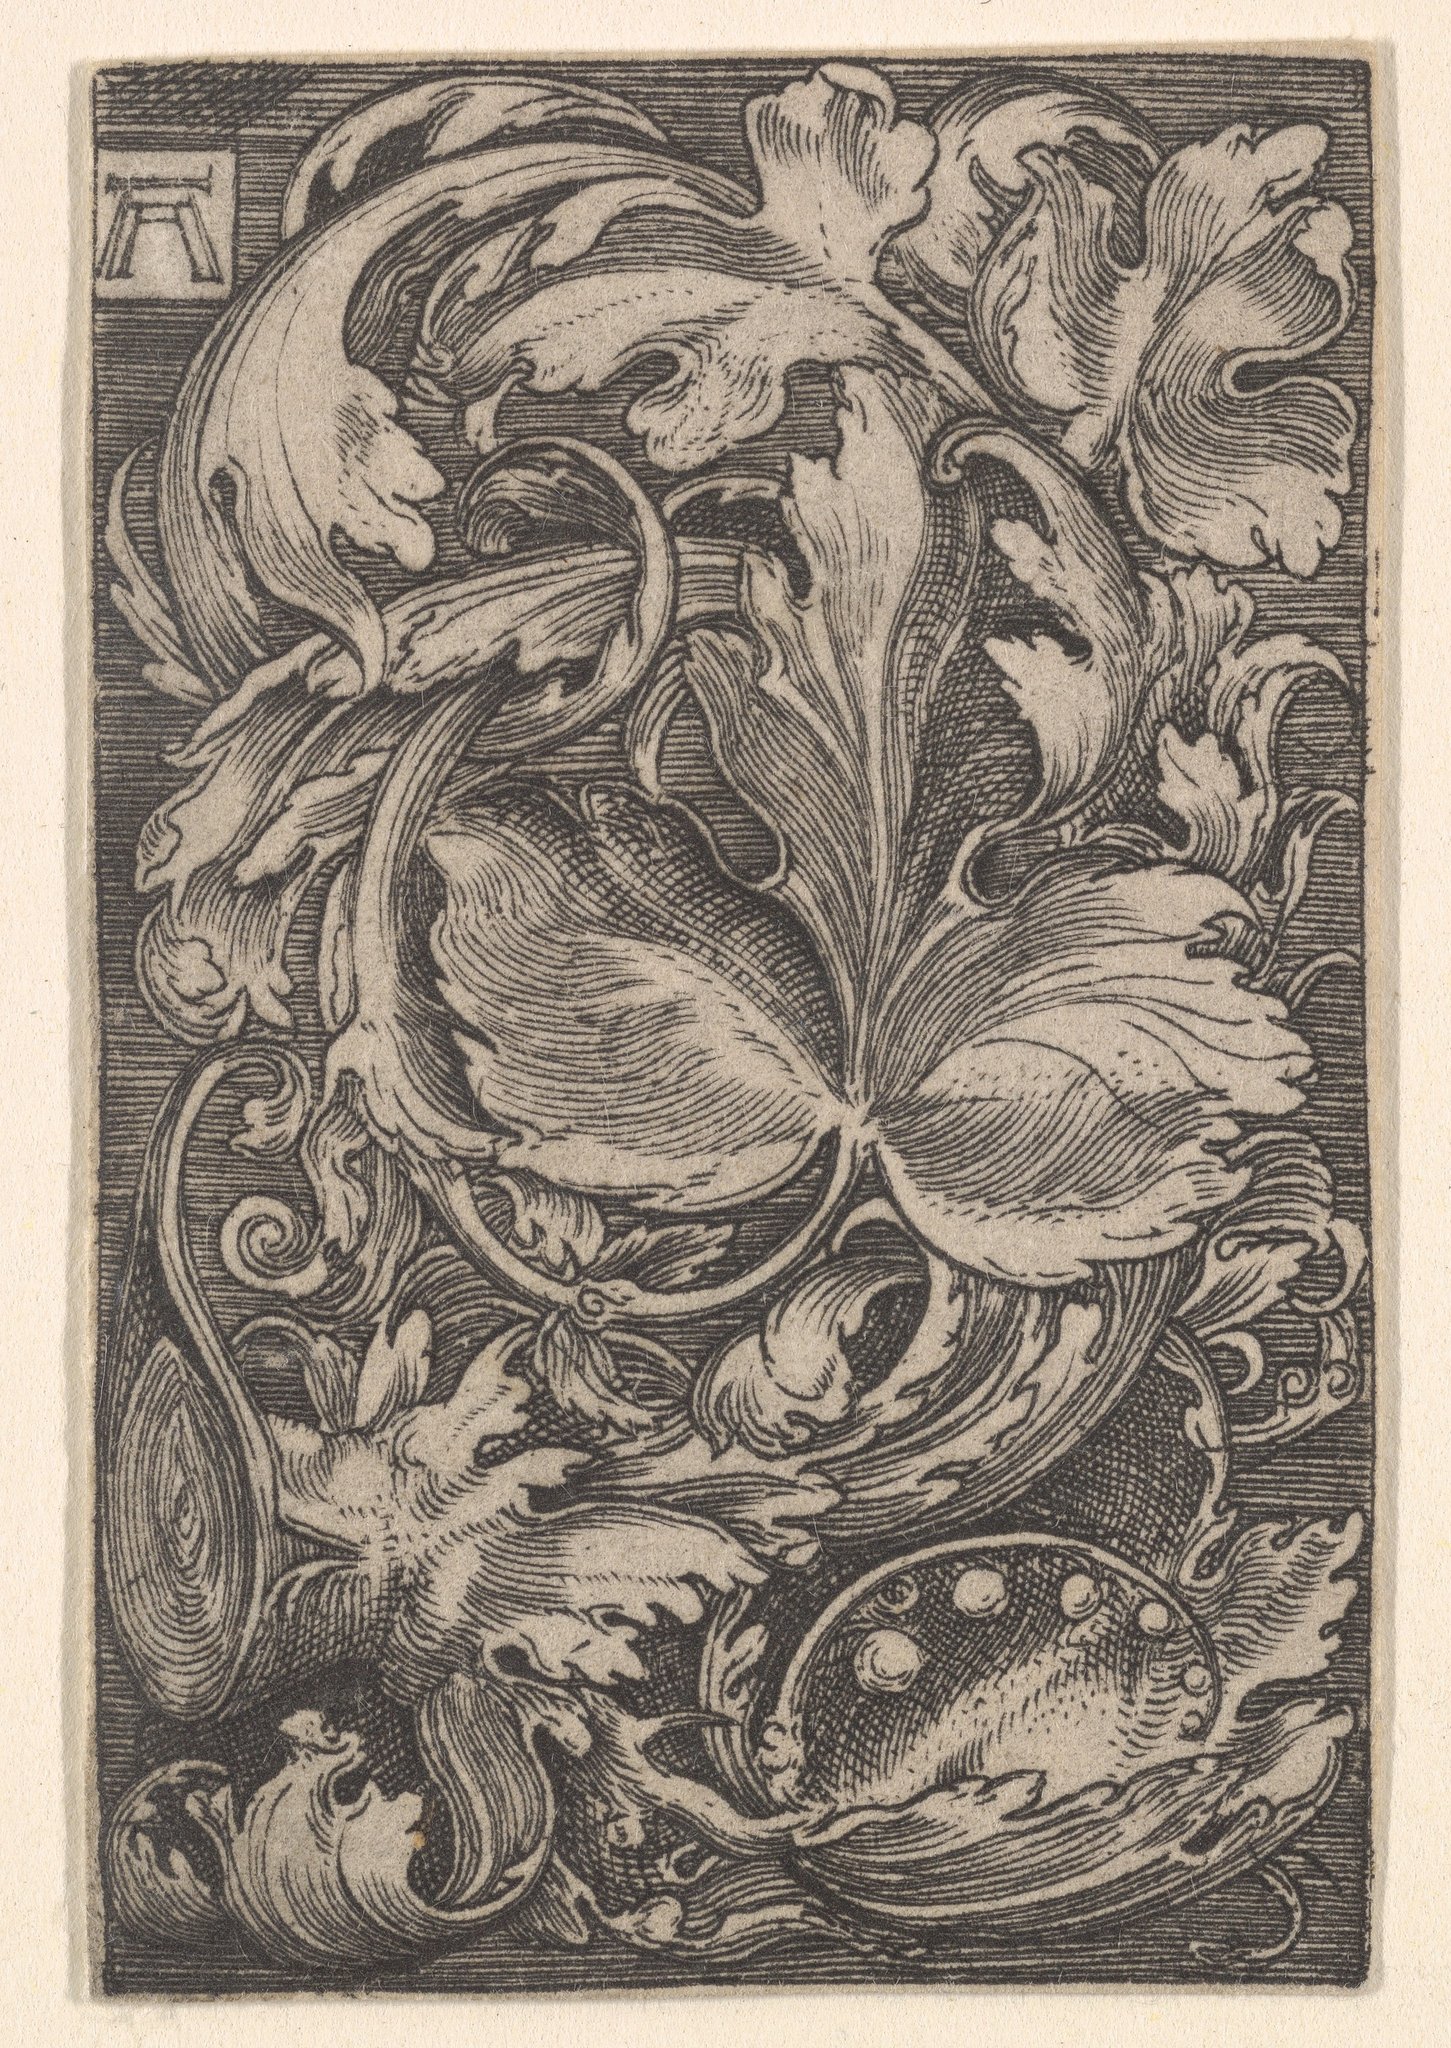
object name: print ornament architecture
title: Copy of Leaf Ornament with Lilies of the Valley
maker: albrecht altdorfer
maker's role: artist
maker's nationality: german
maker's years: 1480-1538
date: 1500-1538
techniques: engraving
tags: leaves